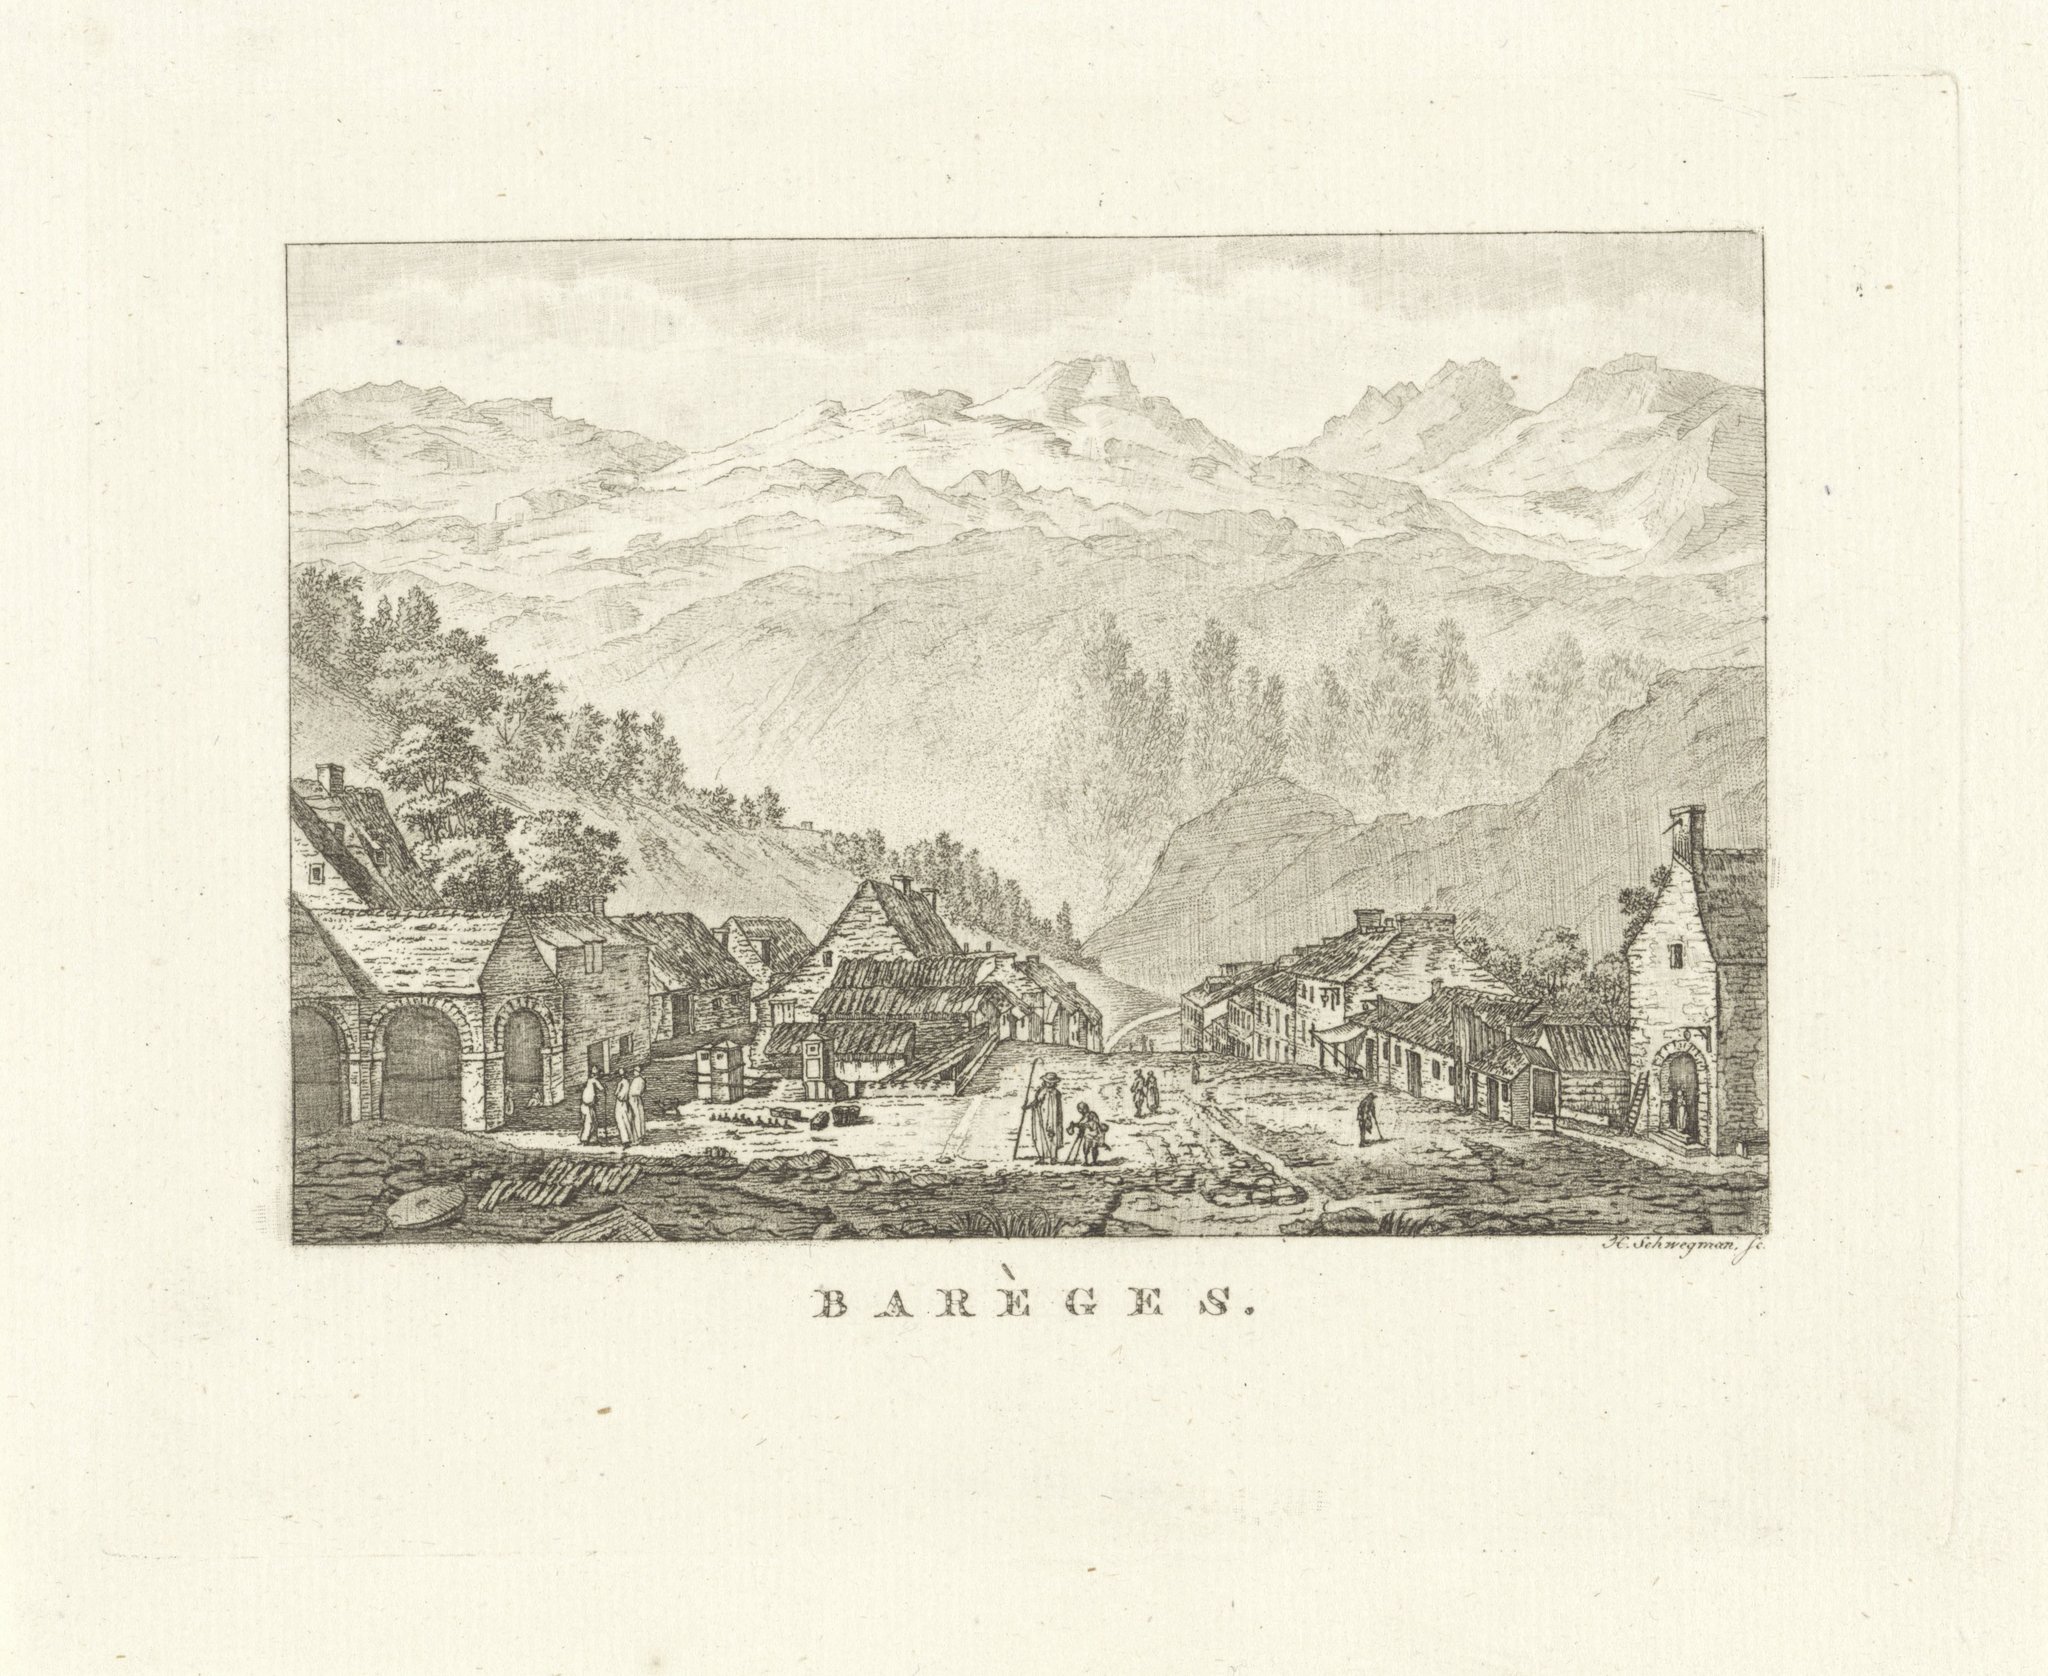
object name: print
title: Gezicht op Barèges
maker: hendrik schwegman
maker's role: draughtsman, print maker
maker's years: 1761-1816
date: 1771-1816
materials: paper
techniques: etching, roulette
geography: haarlem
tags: village, mountains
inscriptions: collector's mark: Lugt 2228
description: Gezicht op het dorp Barèges met de bergen op de achtergrond.